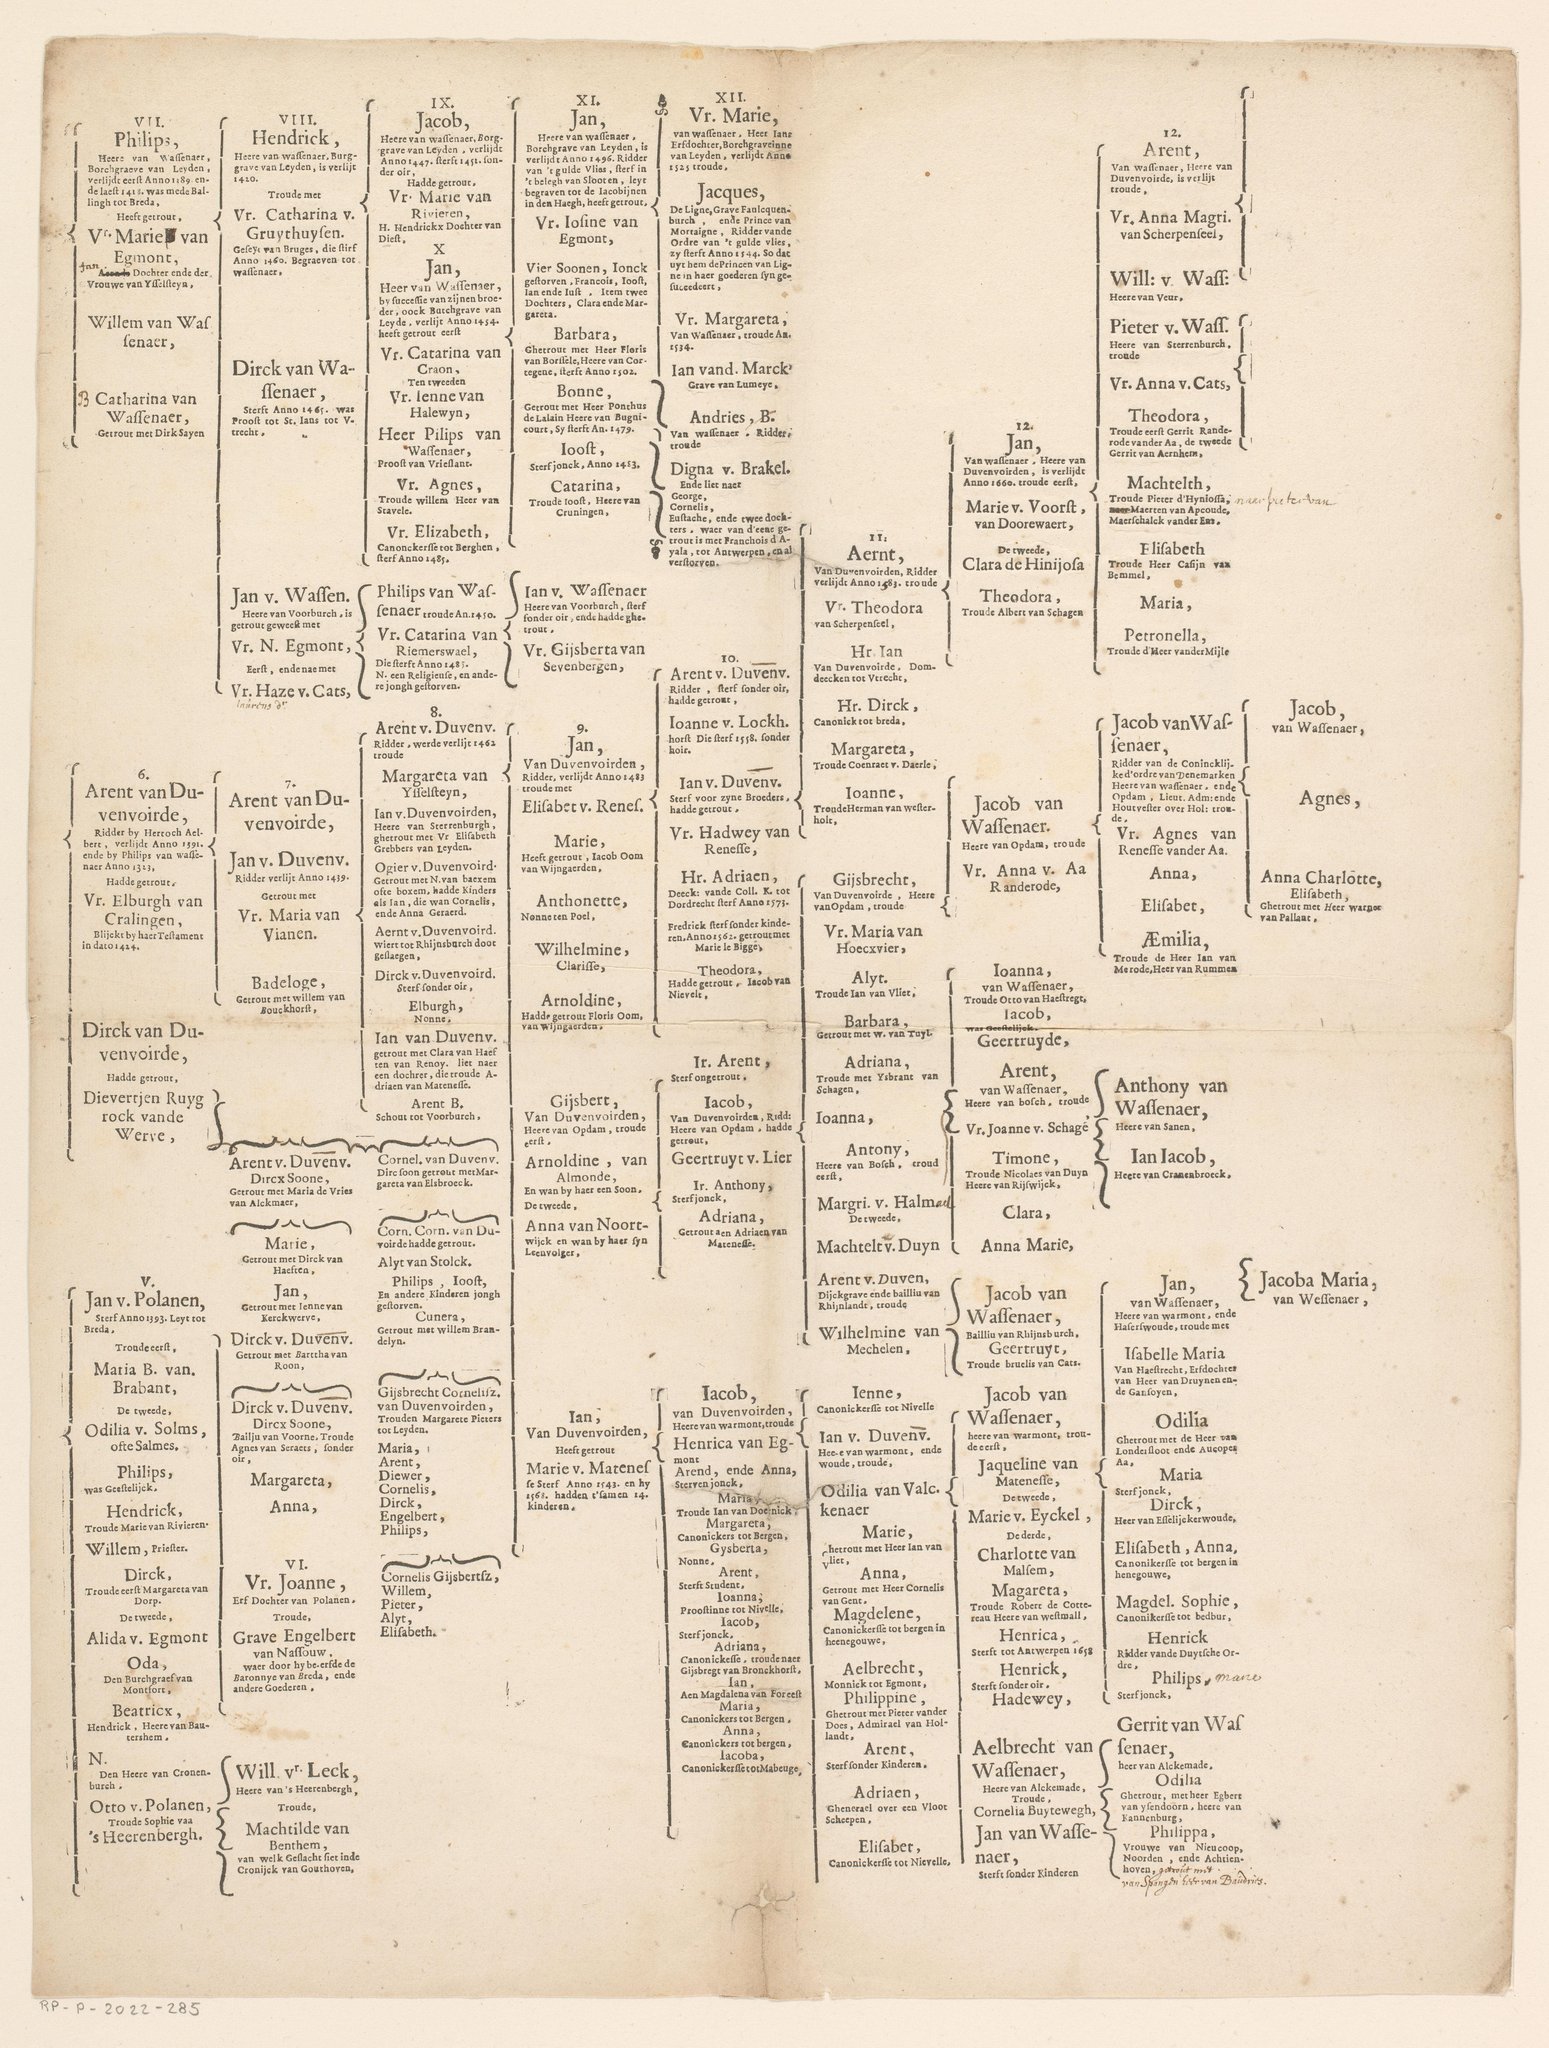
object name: text sheet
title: Verkorte genealogie, ofte aenwijsinge van den seer ouden en doorluchtigen stamme Van Wassenaer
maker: Anonymous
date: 1650-1670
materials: paper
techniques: letterpress printing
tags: family lineage, pedigree, genealogical tree or table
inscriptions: collector's mark: Lugt 2228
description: Zie RP-P-2022-284 voor het begin van de tabel.